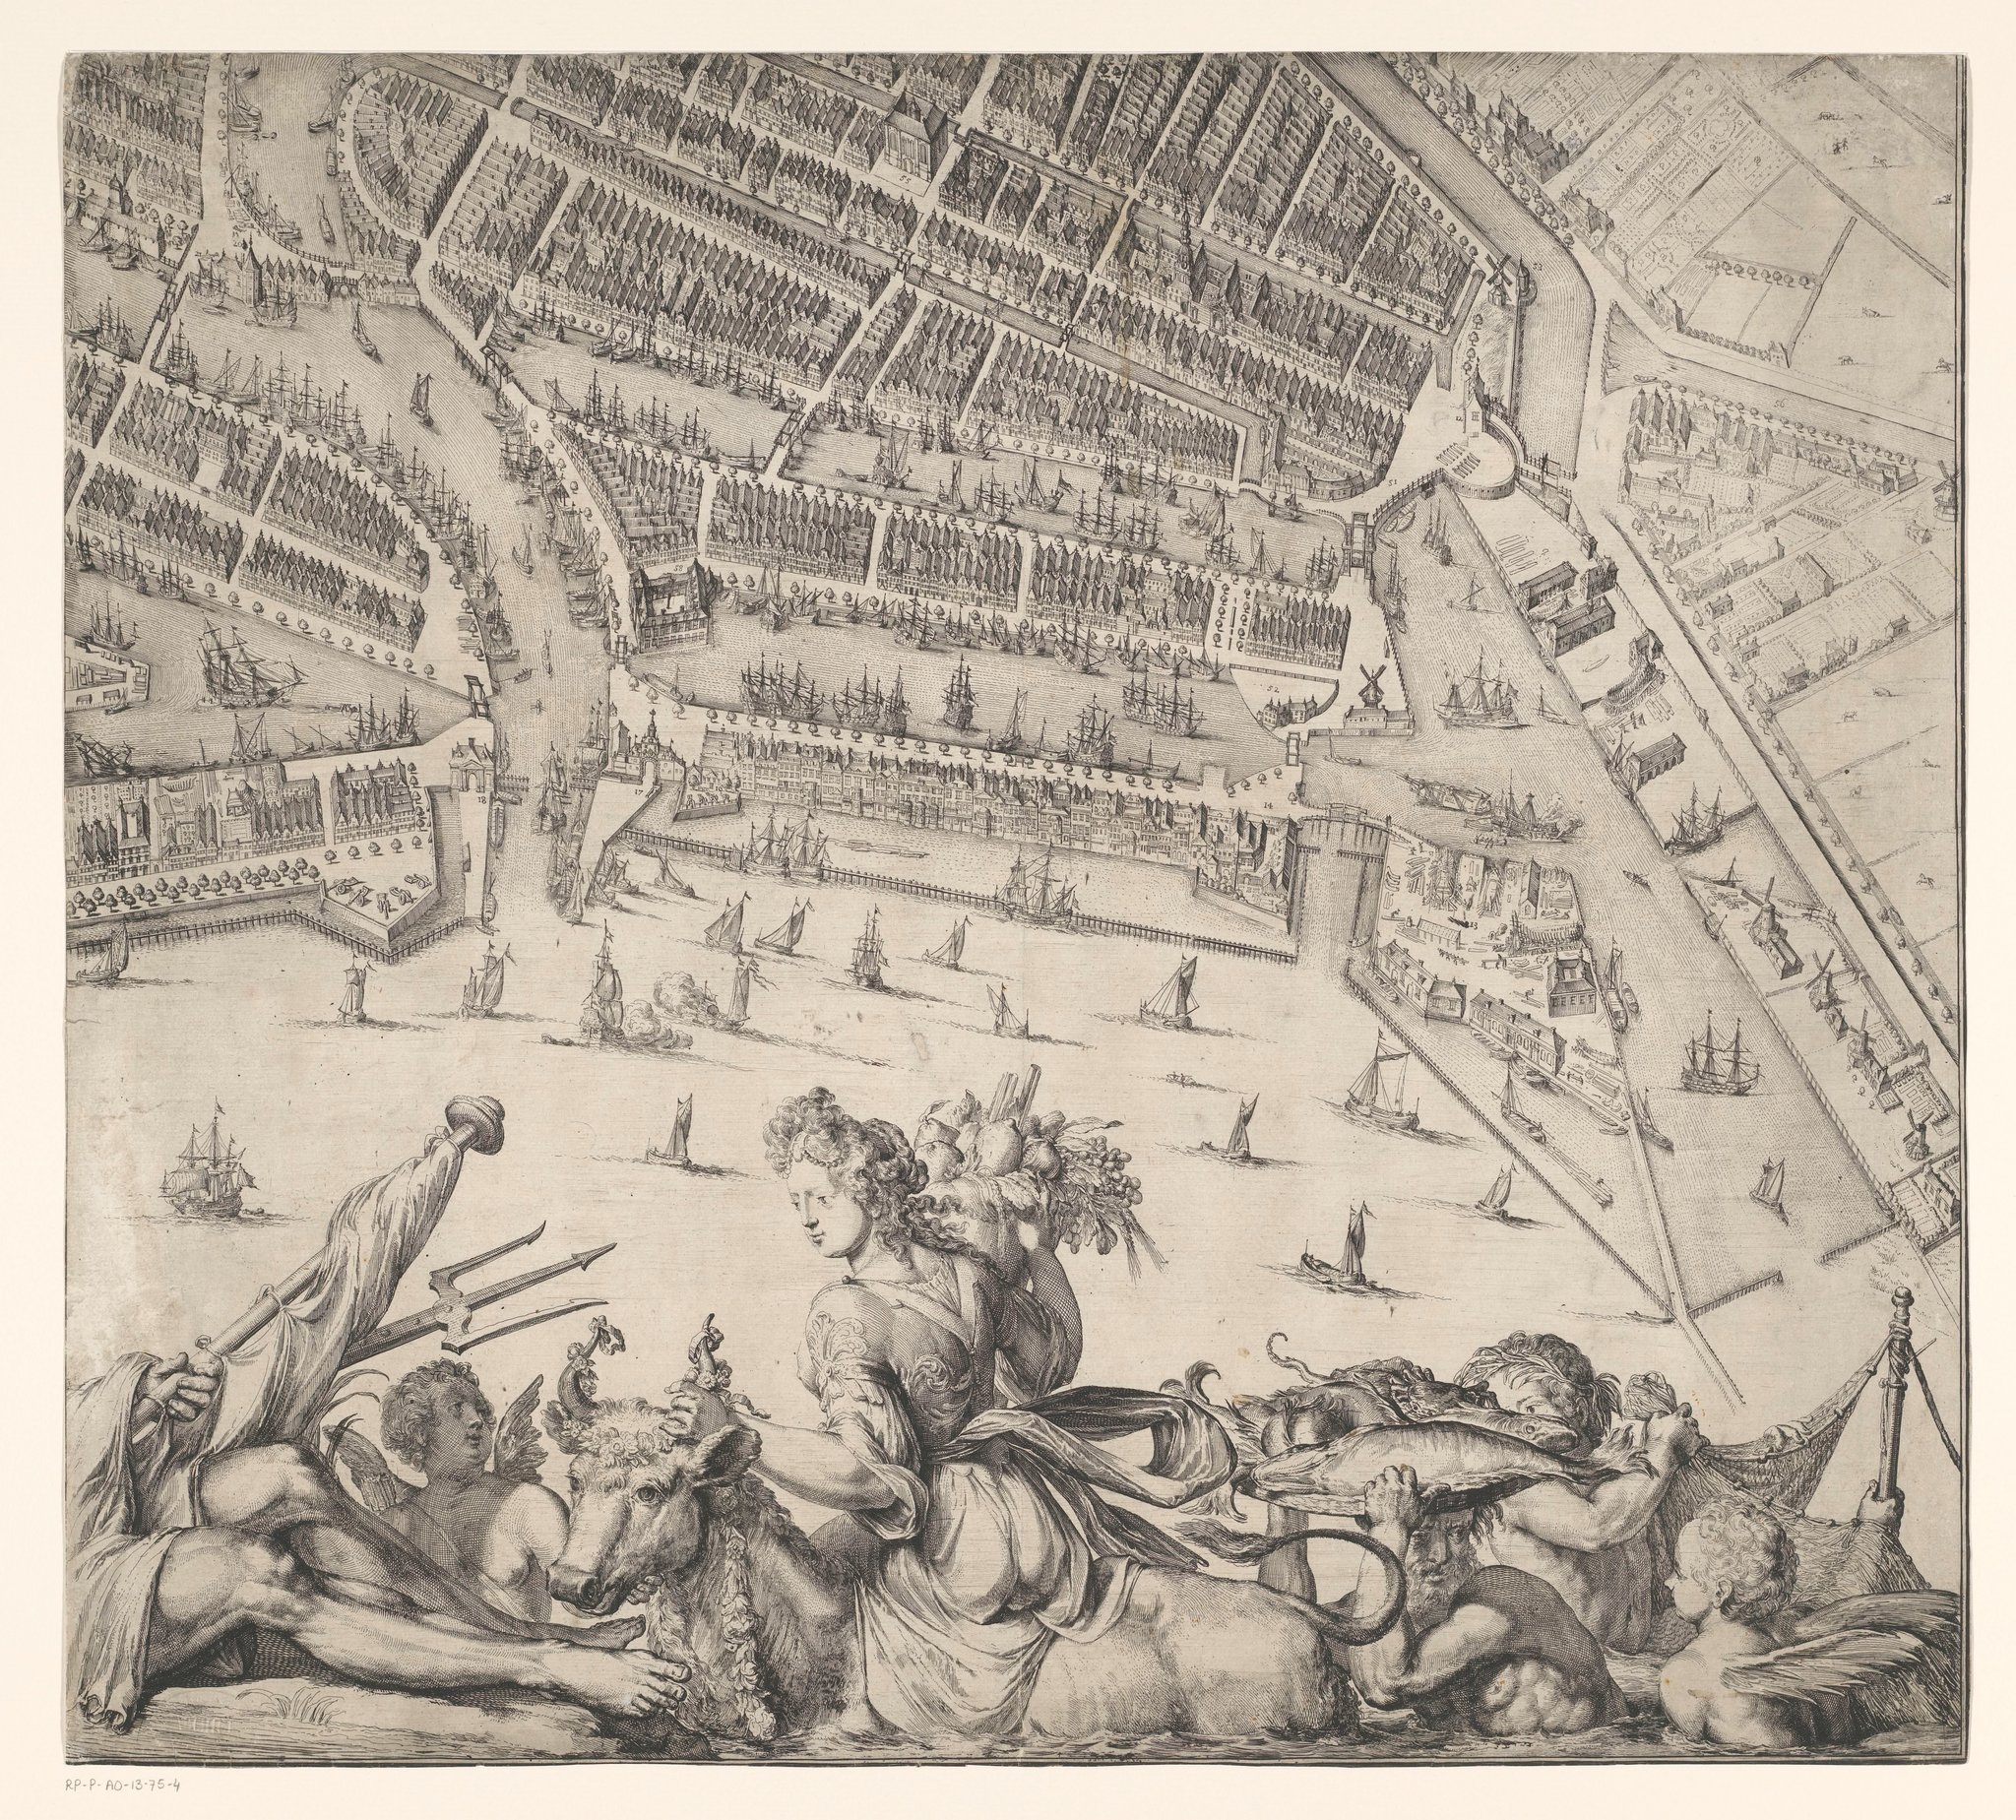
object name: area plan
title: Rotterodamum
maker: romeyn de hooghe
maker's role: draughtsman, goldsmith, painter, print maker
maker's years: 1645-1708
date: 1691-1692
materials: paper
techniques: engraving, etching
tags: 'cornucopia', horn of plenty, triton(s), europe represented allegorically; 'europa' (ripa), river-gods, maps of cities, rotterdam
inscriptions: collector's mark: Lugt 2228, check stamp: ‘Archief Ministerie van Oorlog Afdeeling Genie’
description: Deel (rechtsonder) van een vierdelige plattegrond van Rotterdam.